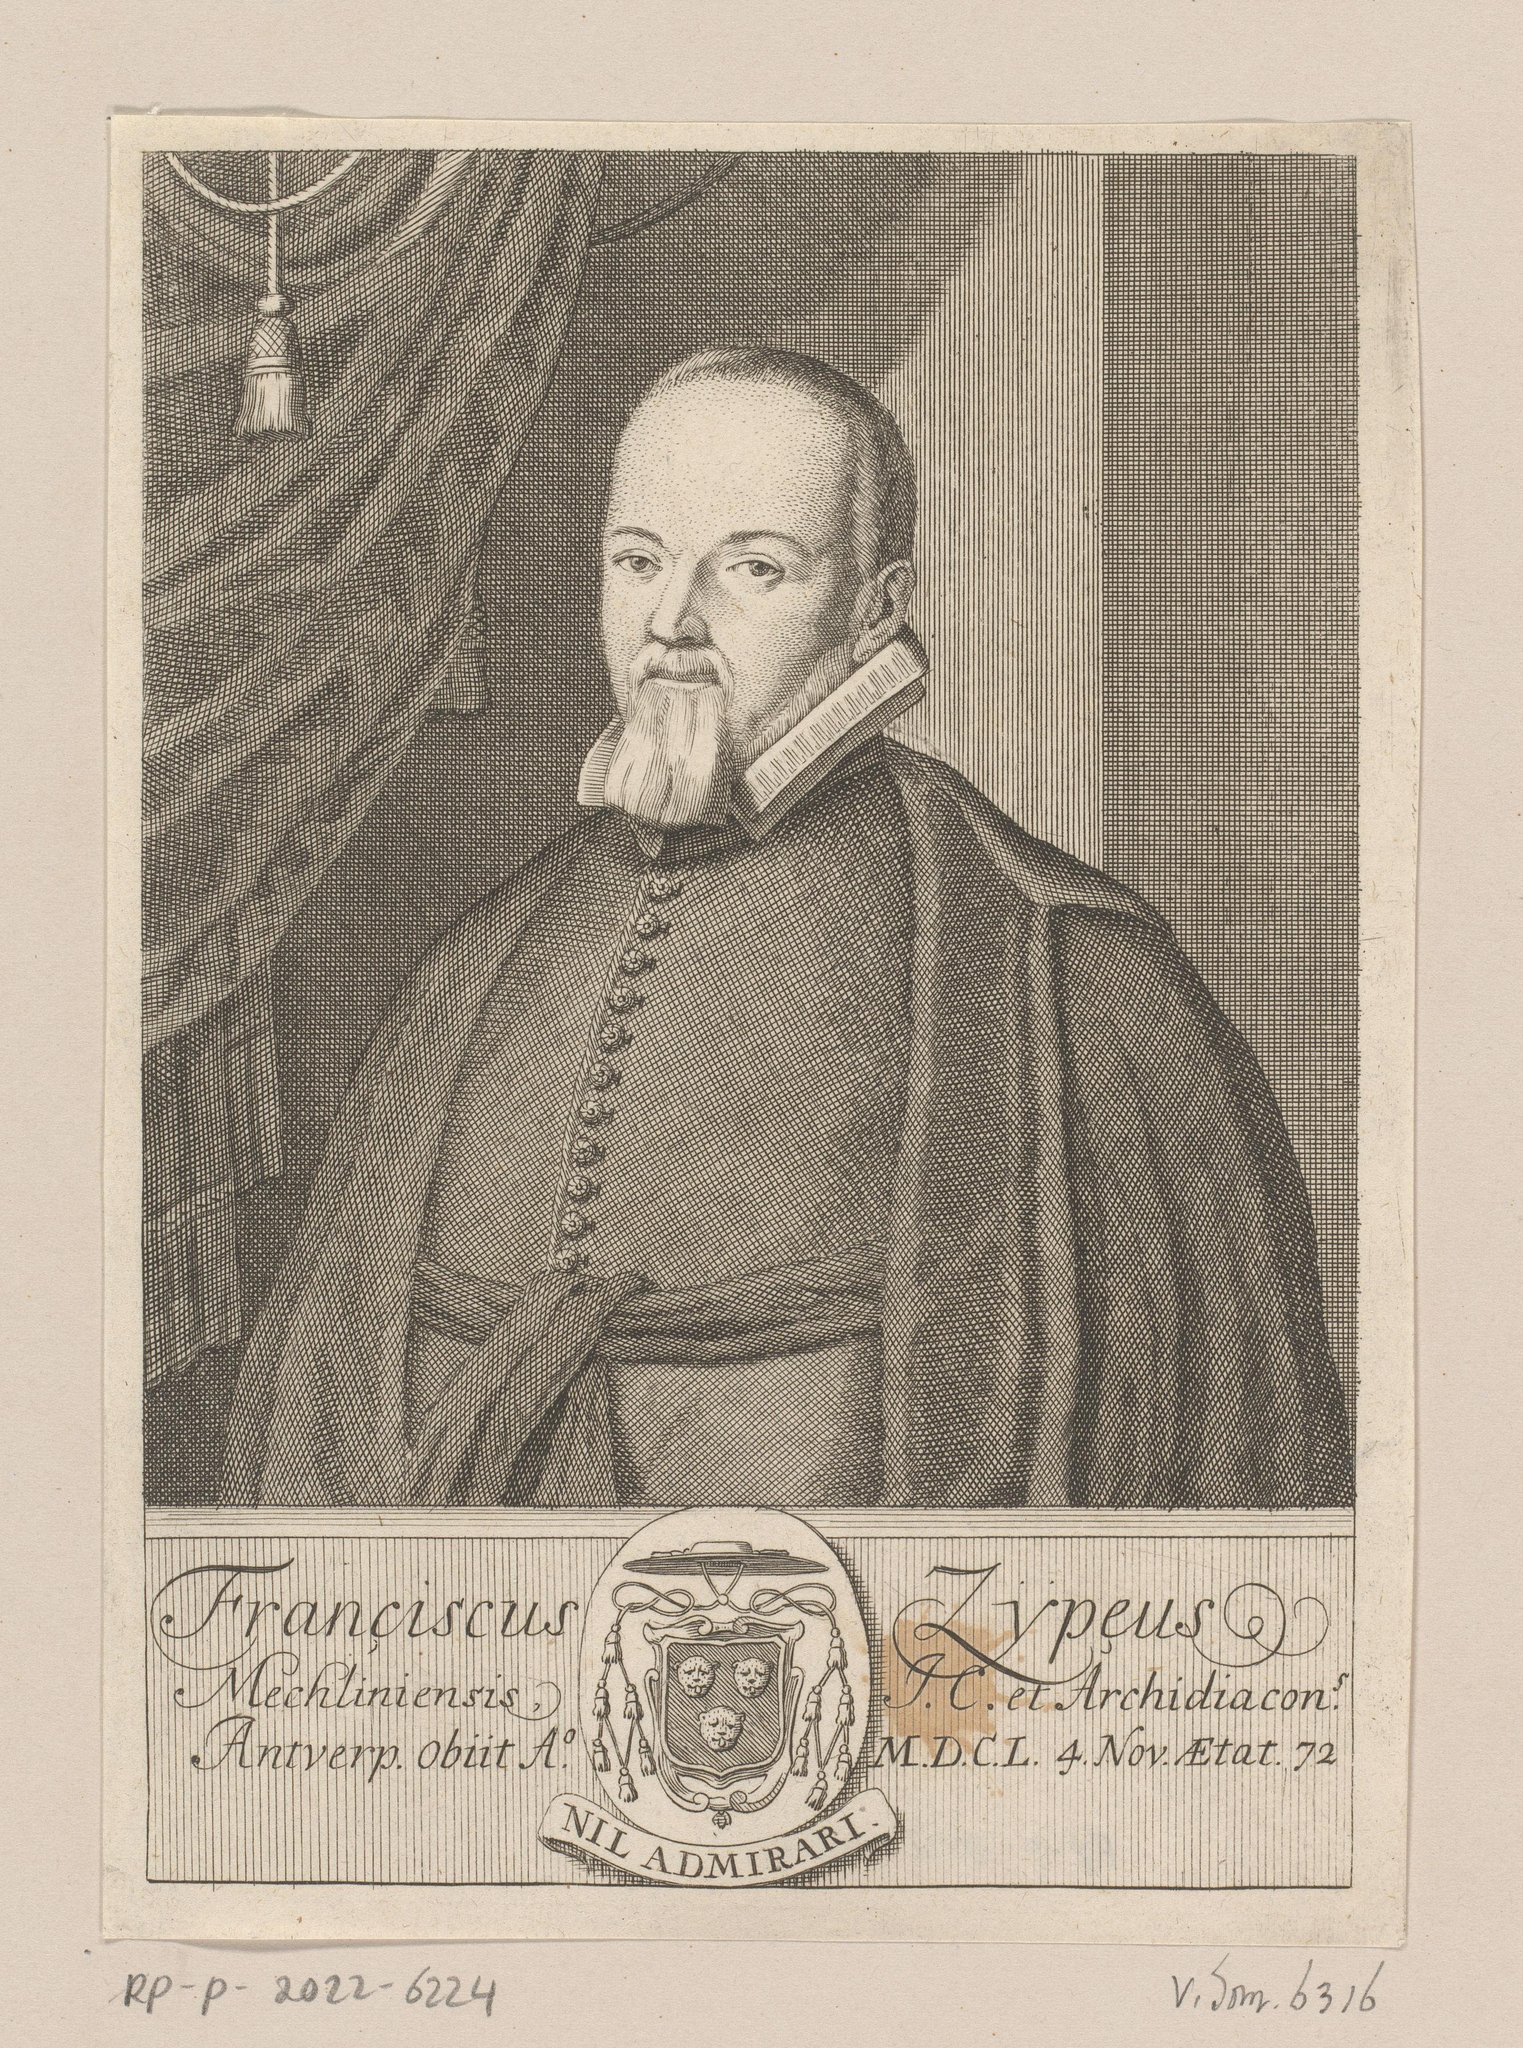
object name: print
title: Portret van Franciscus Zypaeus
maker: Anonymous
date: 1650-1700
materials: paper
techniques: engraving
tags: antwerp, priest, historical persons, prelates, e.g. archdeacon, canon (roman catholic)